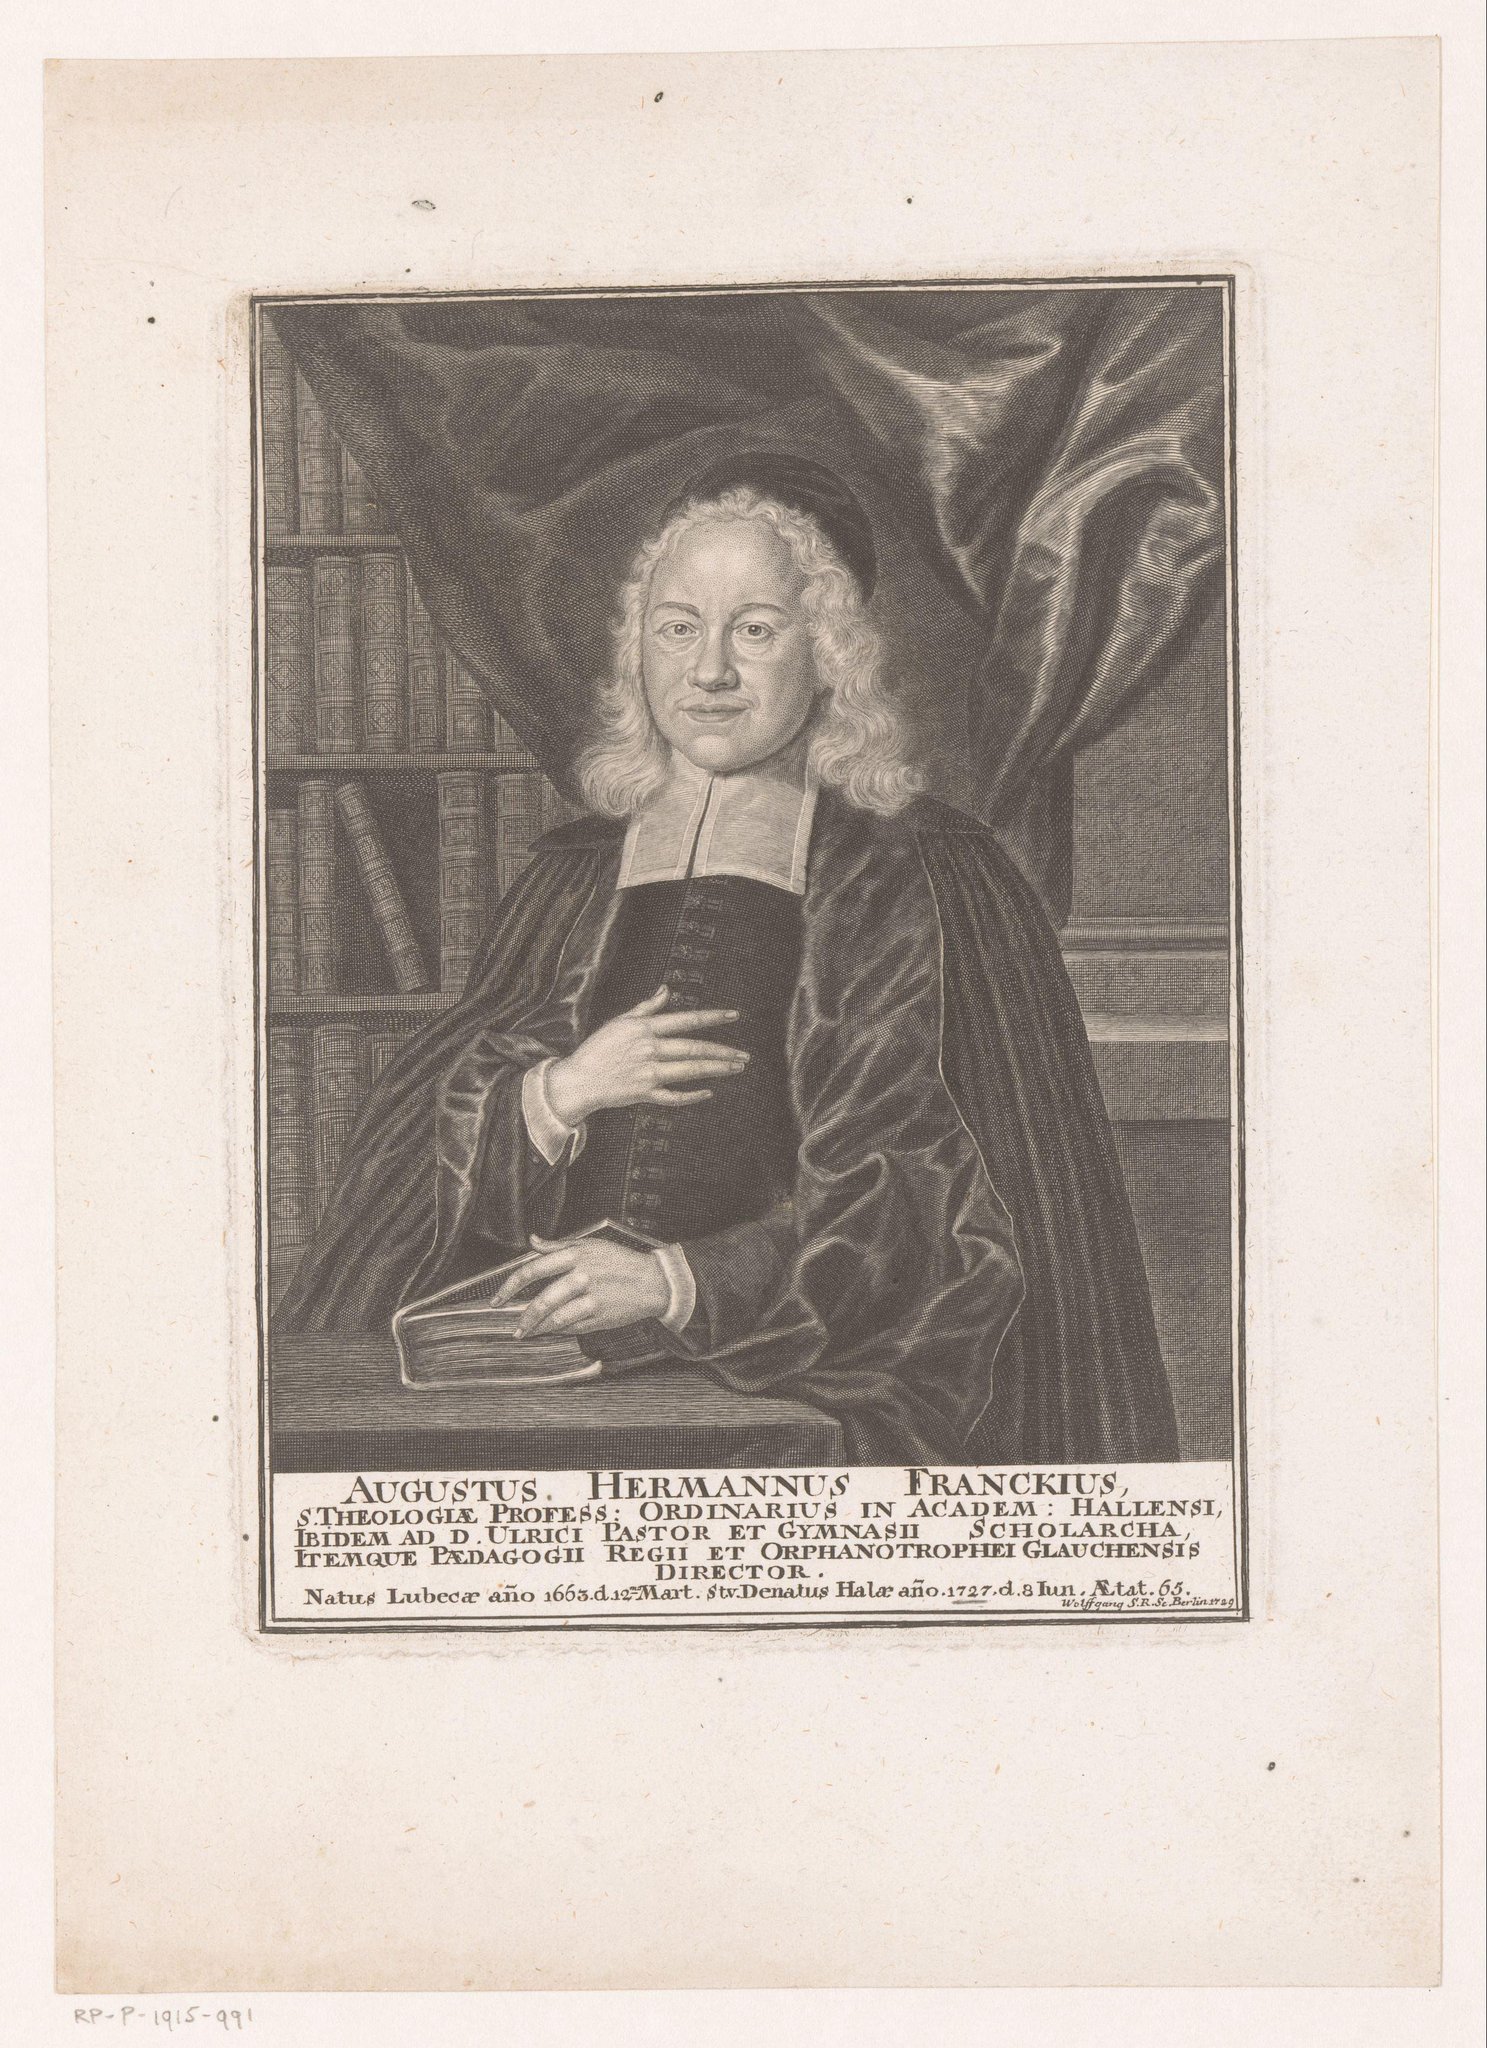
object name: print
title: Portret van August Hermann Francke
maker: johann georg wolfgang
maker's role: graveur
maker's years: 1662-1744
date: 1729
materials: paper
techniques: engraving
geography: berlin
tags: bookshelves, historical persons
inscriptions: collector's mark: Lugt 2228